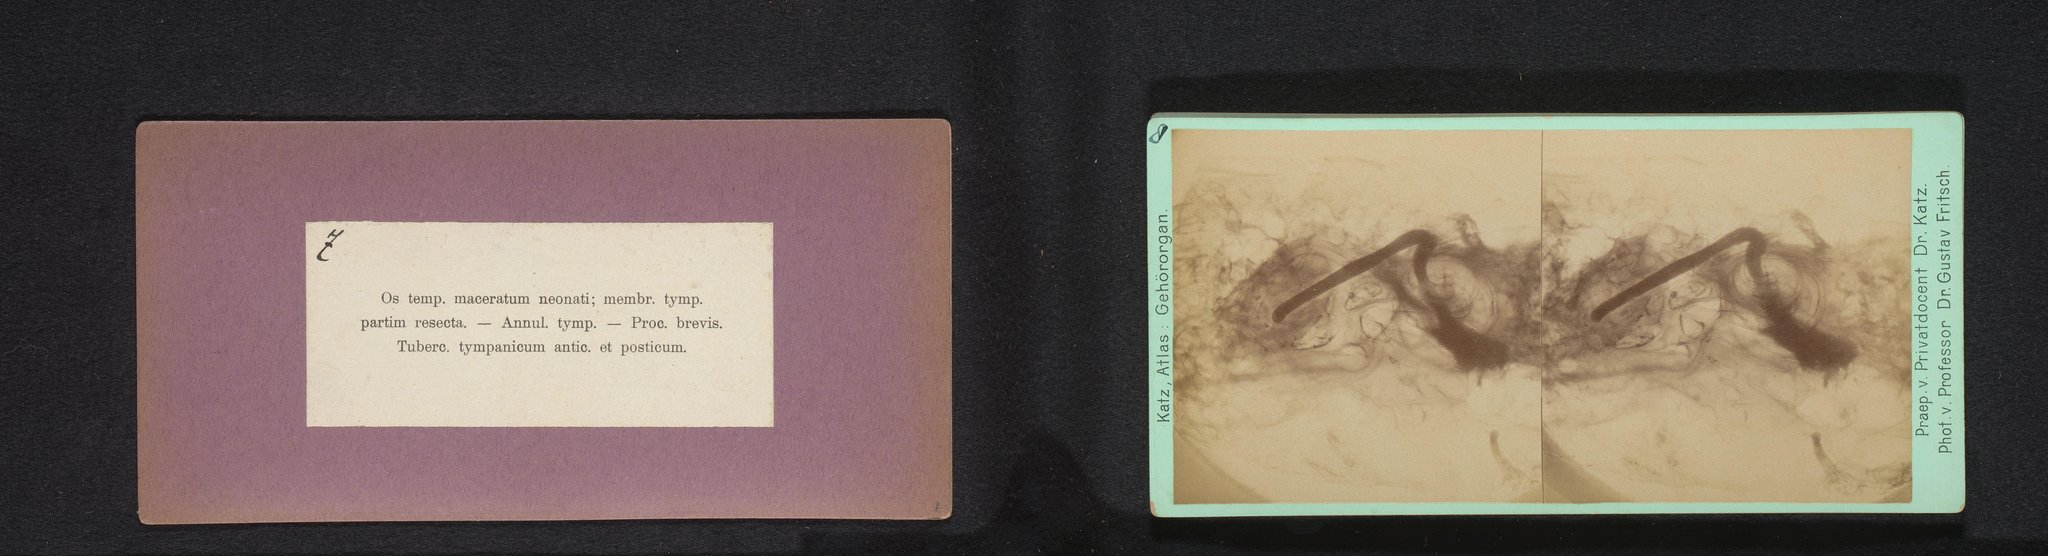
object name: stereograph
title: Microscoopopname van het gehoororgaan van een mens met het labyrint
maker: gustav fritsch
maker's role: professor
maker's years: 1838-1927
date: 1885-1895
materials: photographic support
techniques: albumen print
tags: ears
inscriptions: number: ‘8’